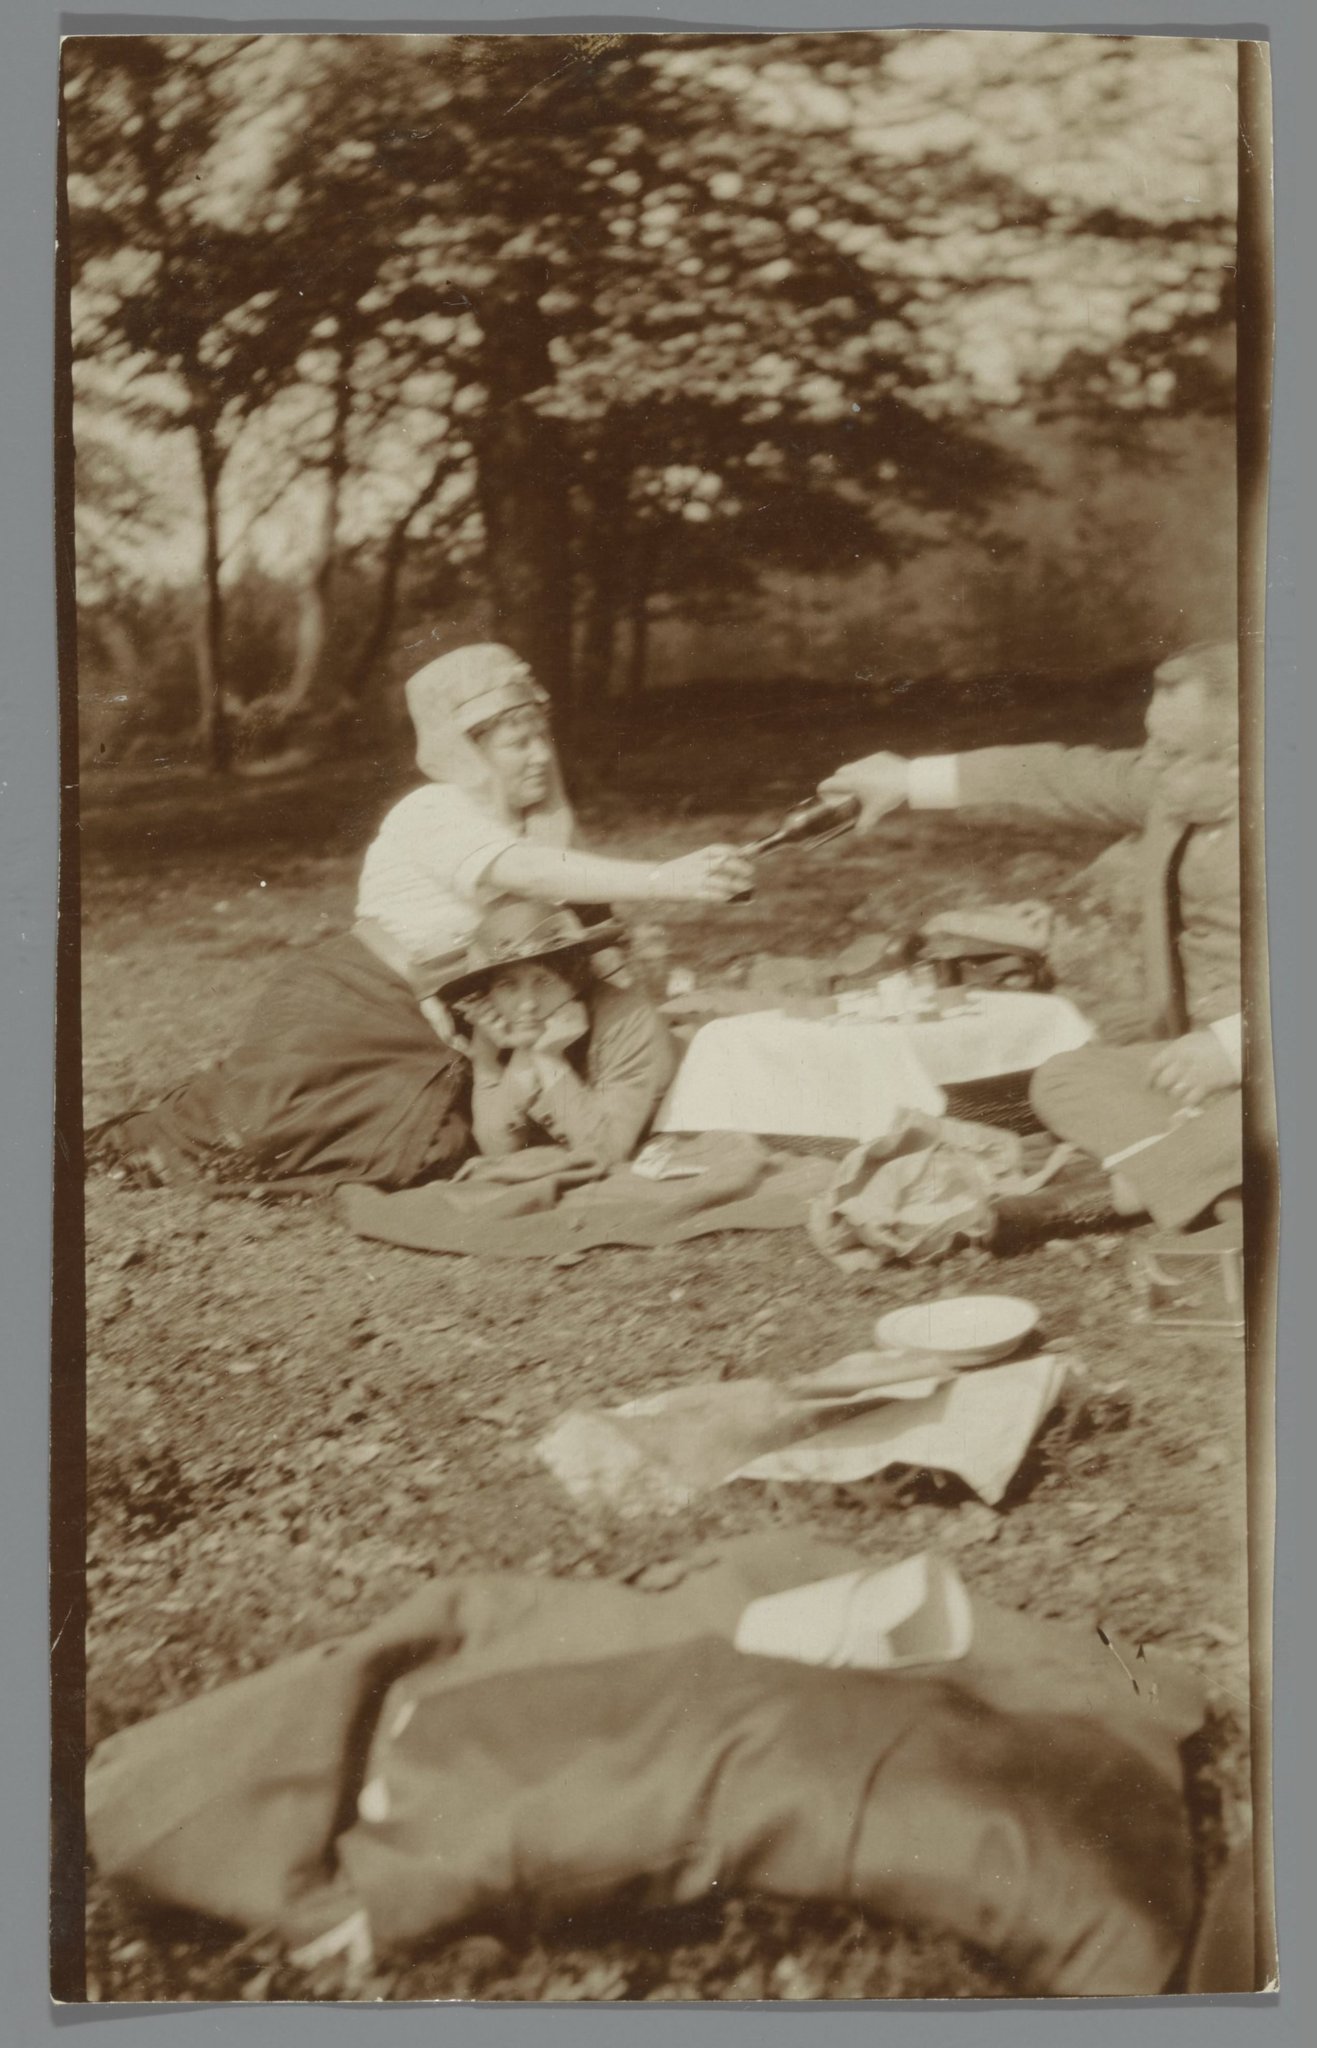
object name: photograph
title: Picnic in park of bos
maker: Anonymous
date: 1900-1910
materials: paper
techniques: gelatin silver print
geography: netherlands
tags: picnic, alfresco, 'déjeuner sur l'herbe'